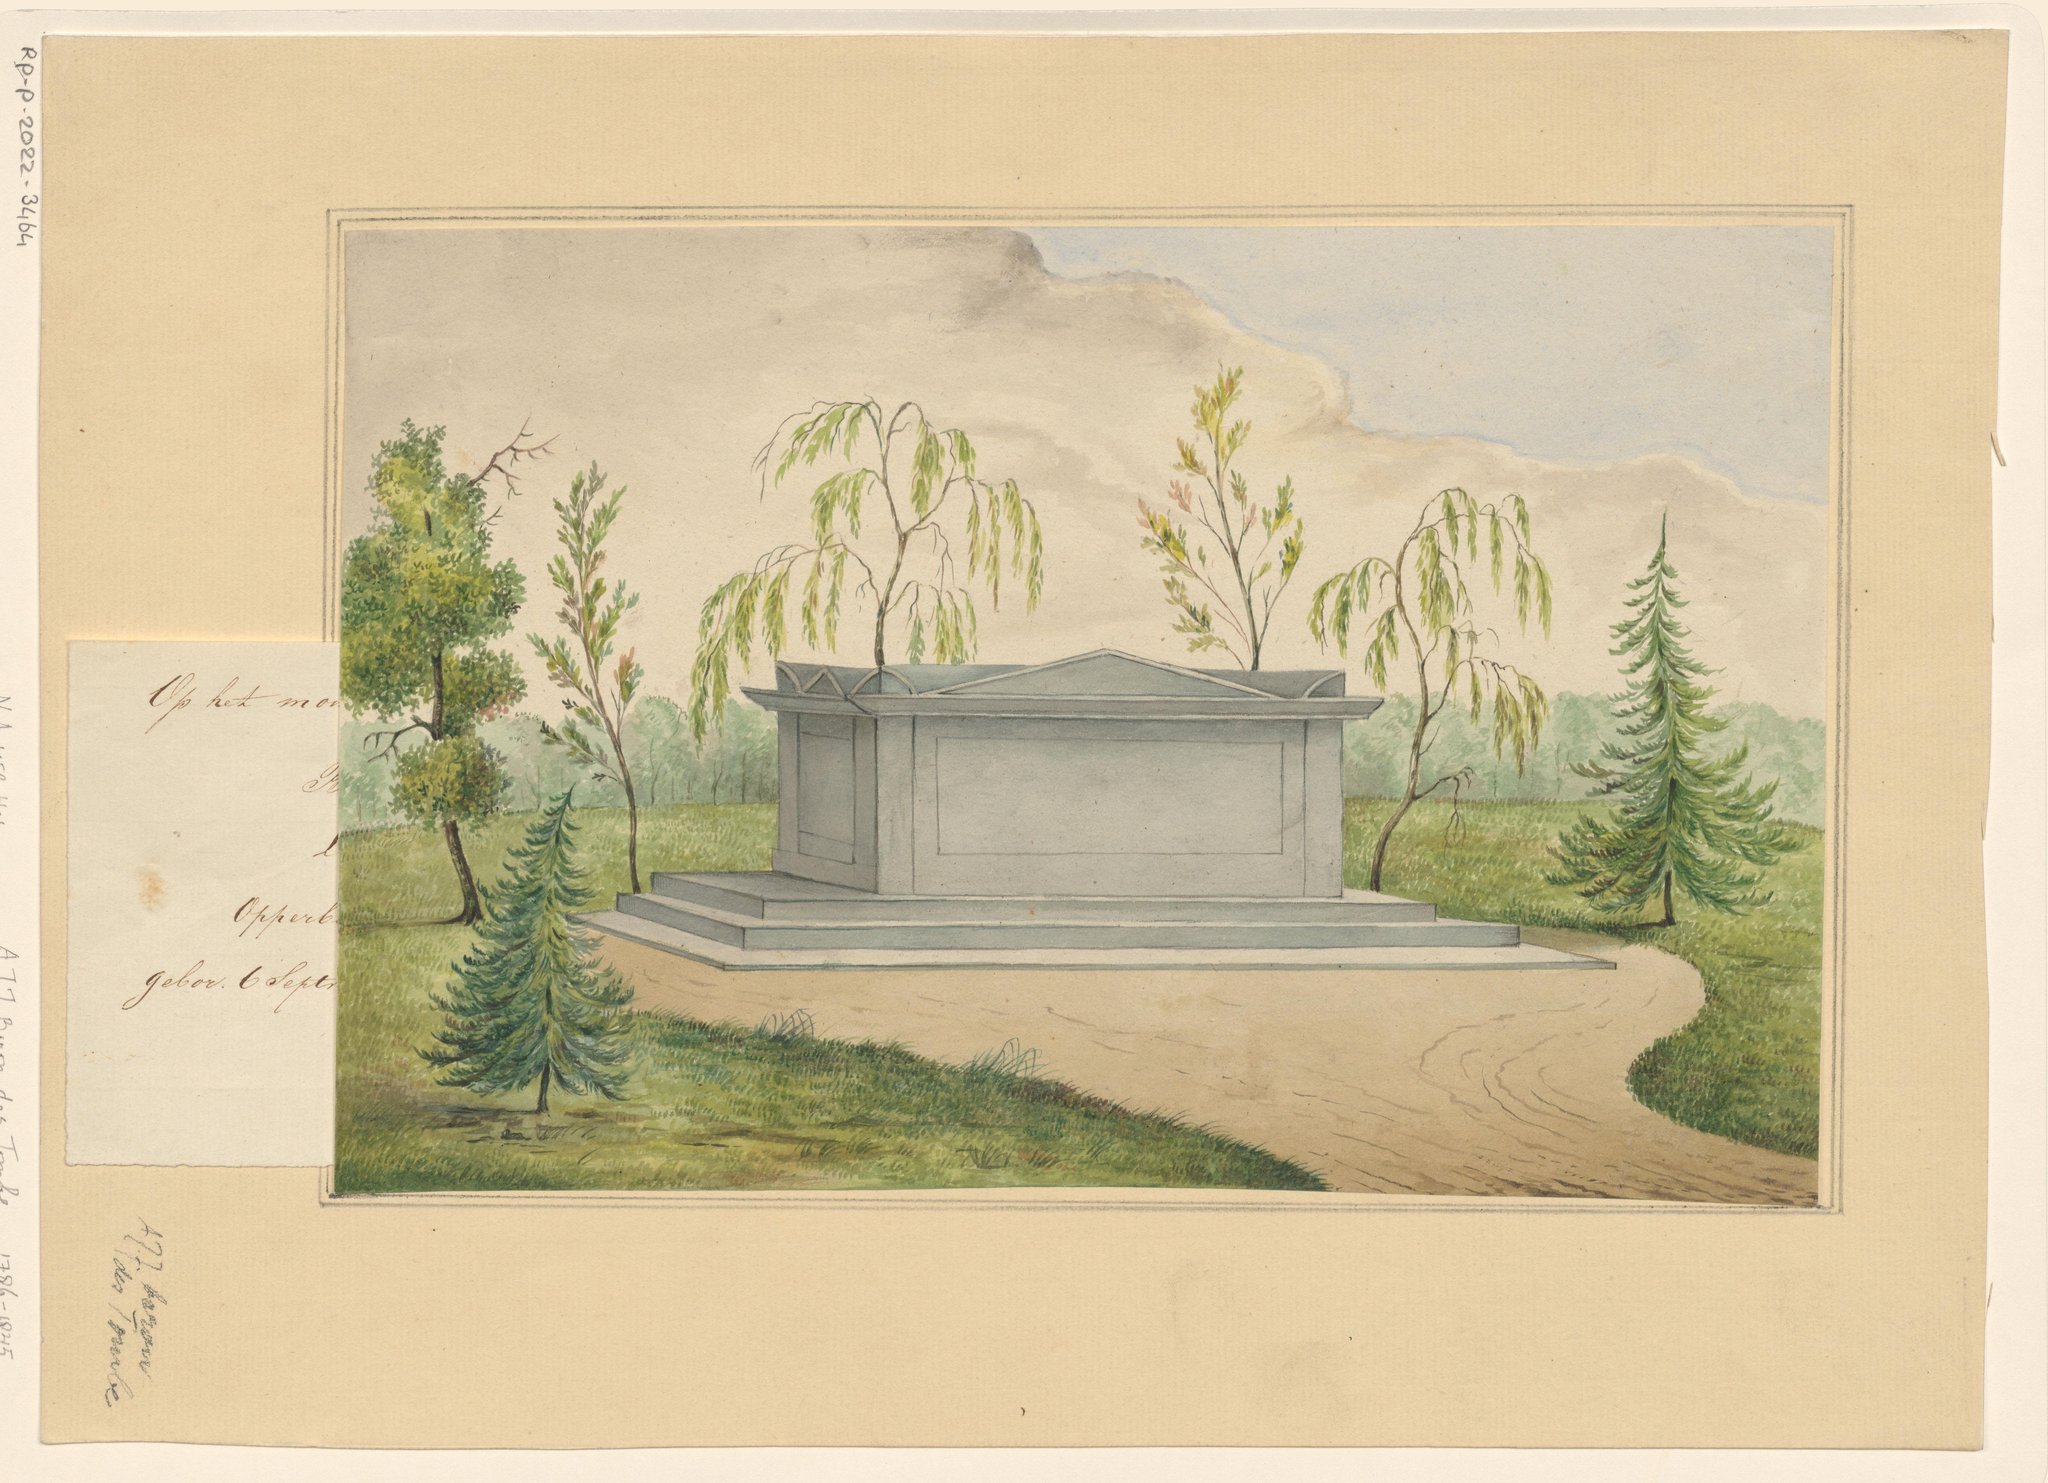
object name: drawing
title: Graftombe van Andries Jan Jacob des Tombe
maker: Anonymous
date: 1845-1899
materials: paper, watercolor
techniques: brush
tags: grave-building, monumental tomb, maastricht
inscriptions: inscription